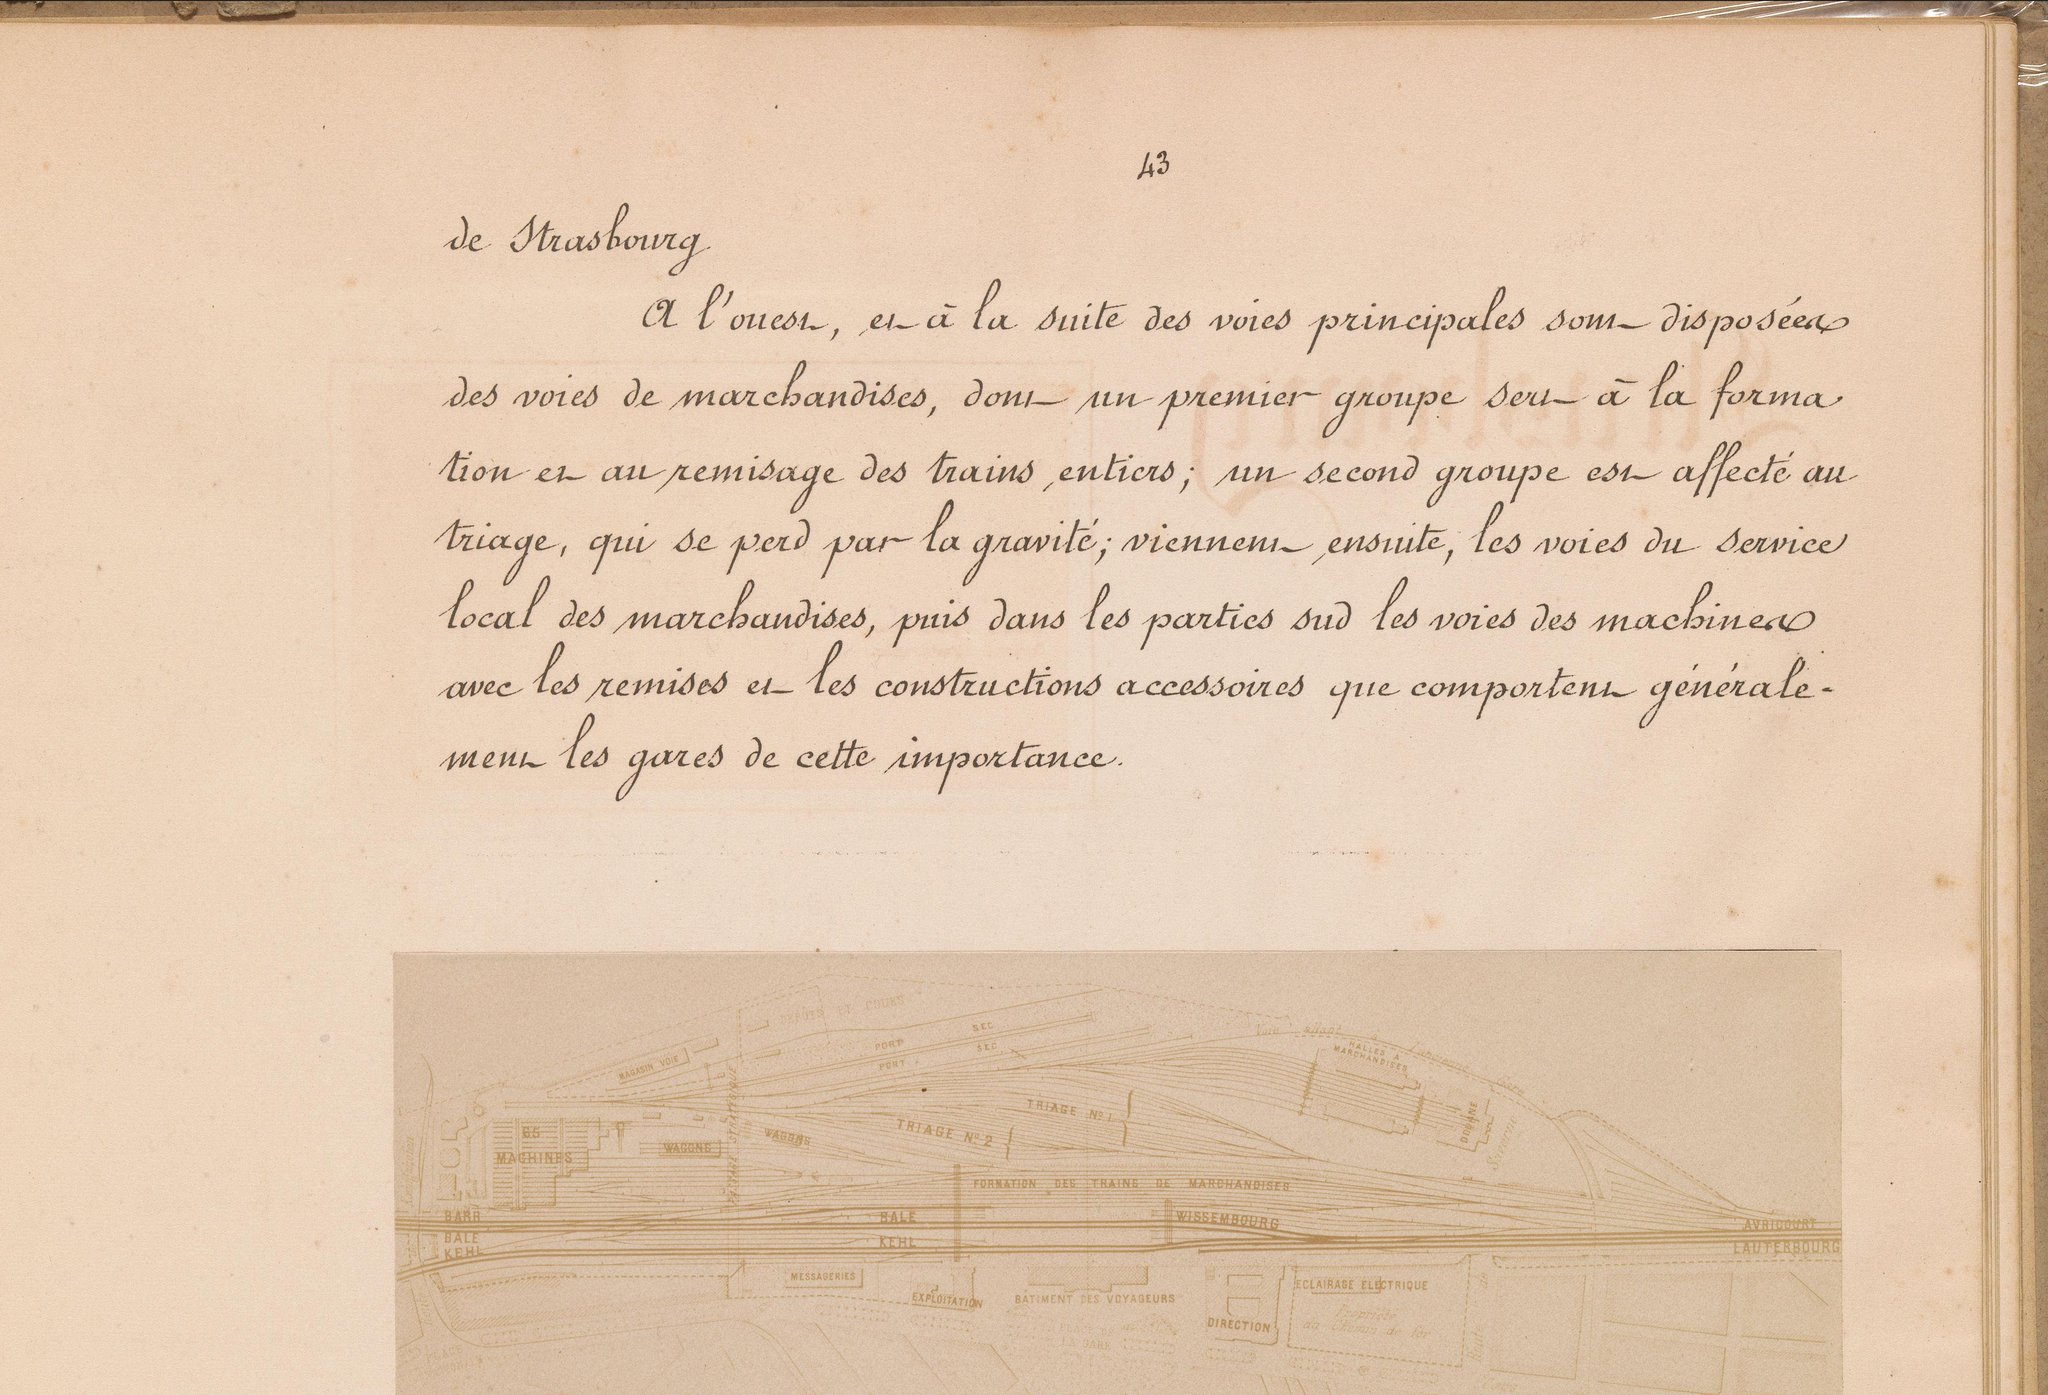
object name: page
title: Fotoreproductie van een kaart van de spoorwegen te Straatsburg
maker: Anonymous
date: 1874-1884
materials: photographic support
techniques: albumen print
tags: maps, atlases, railway, train